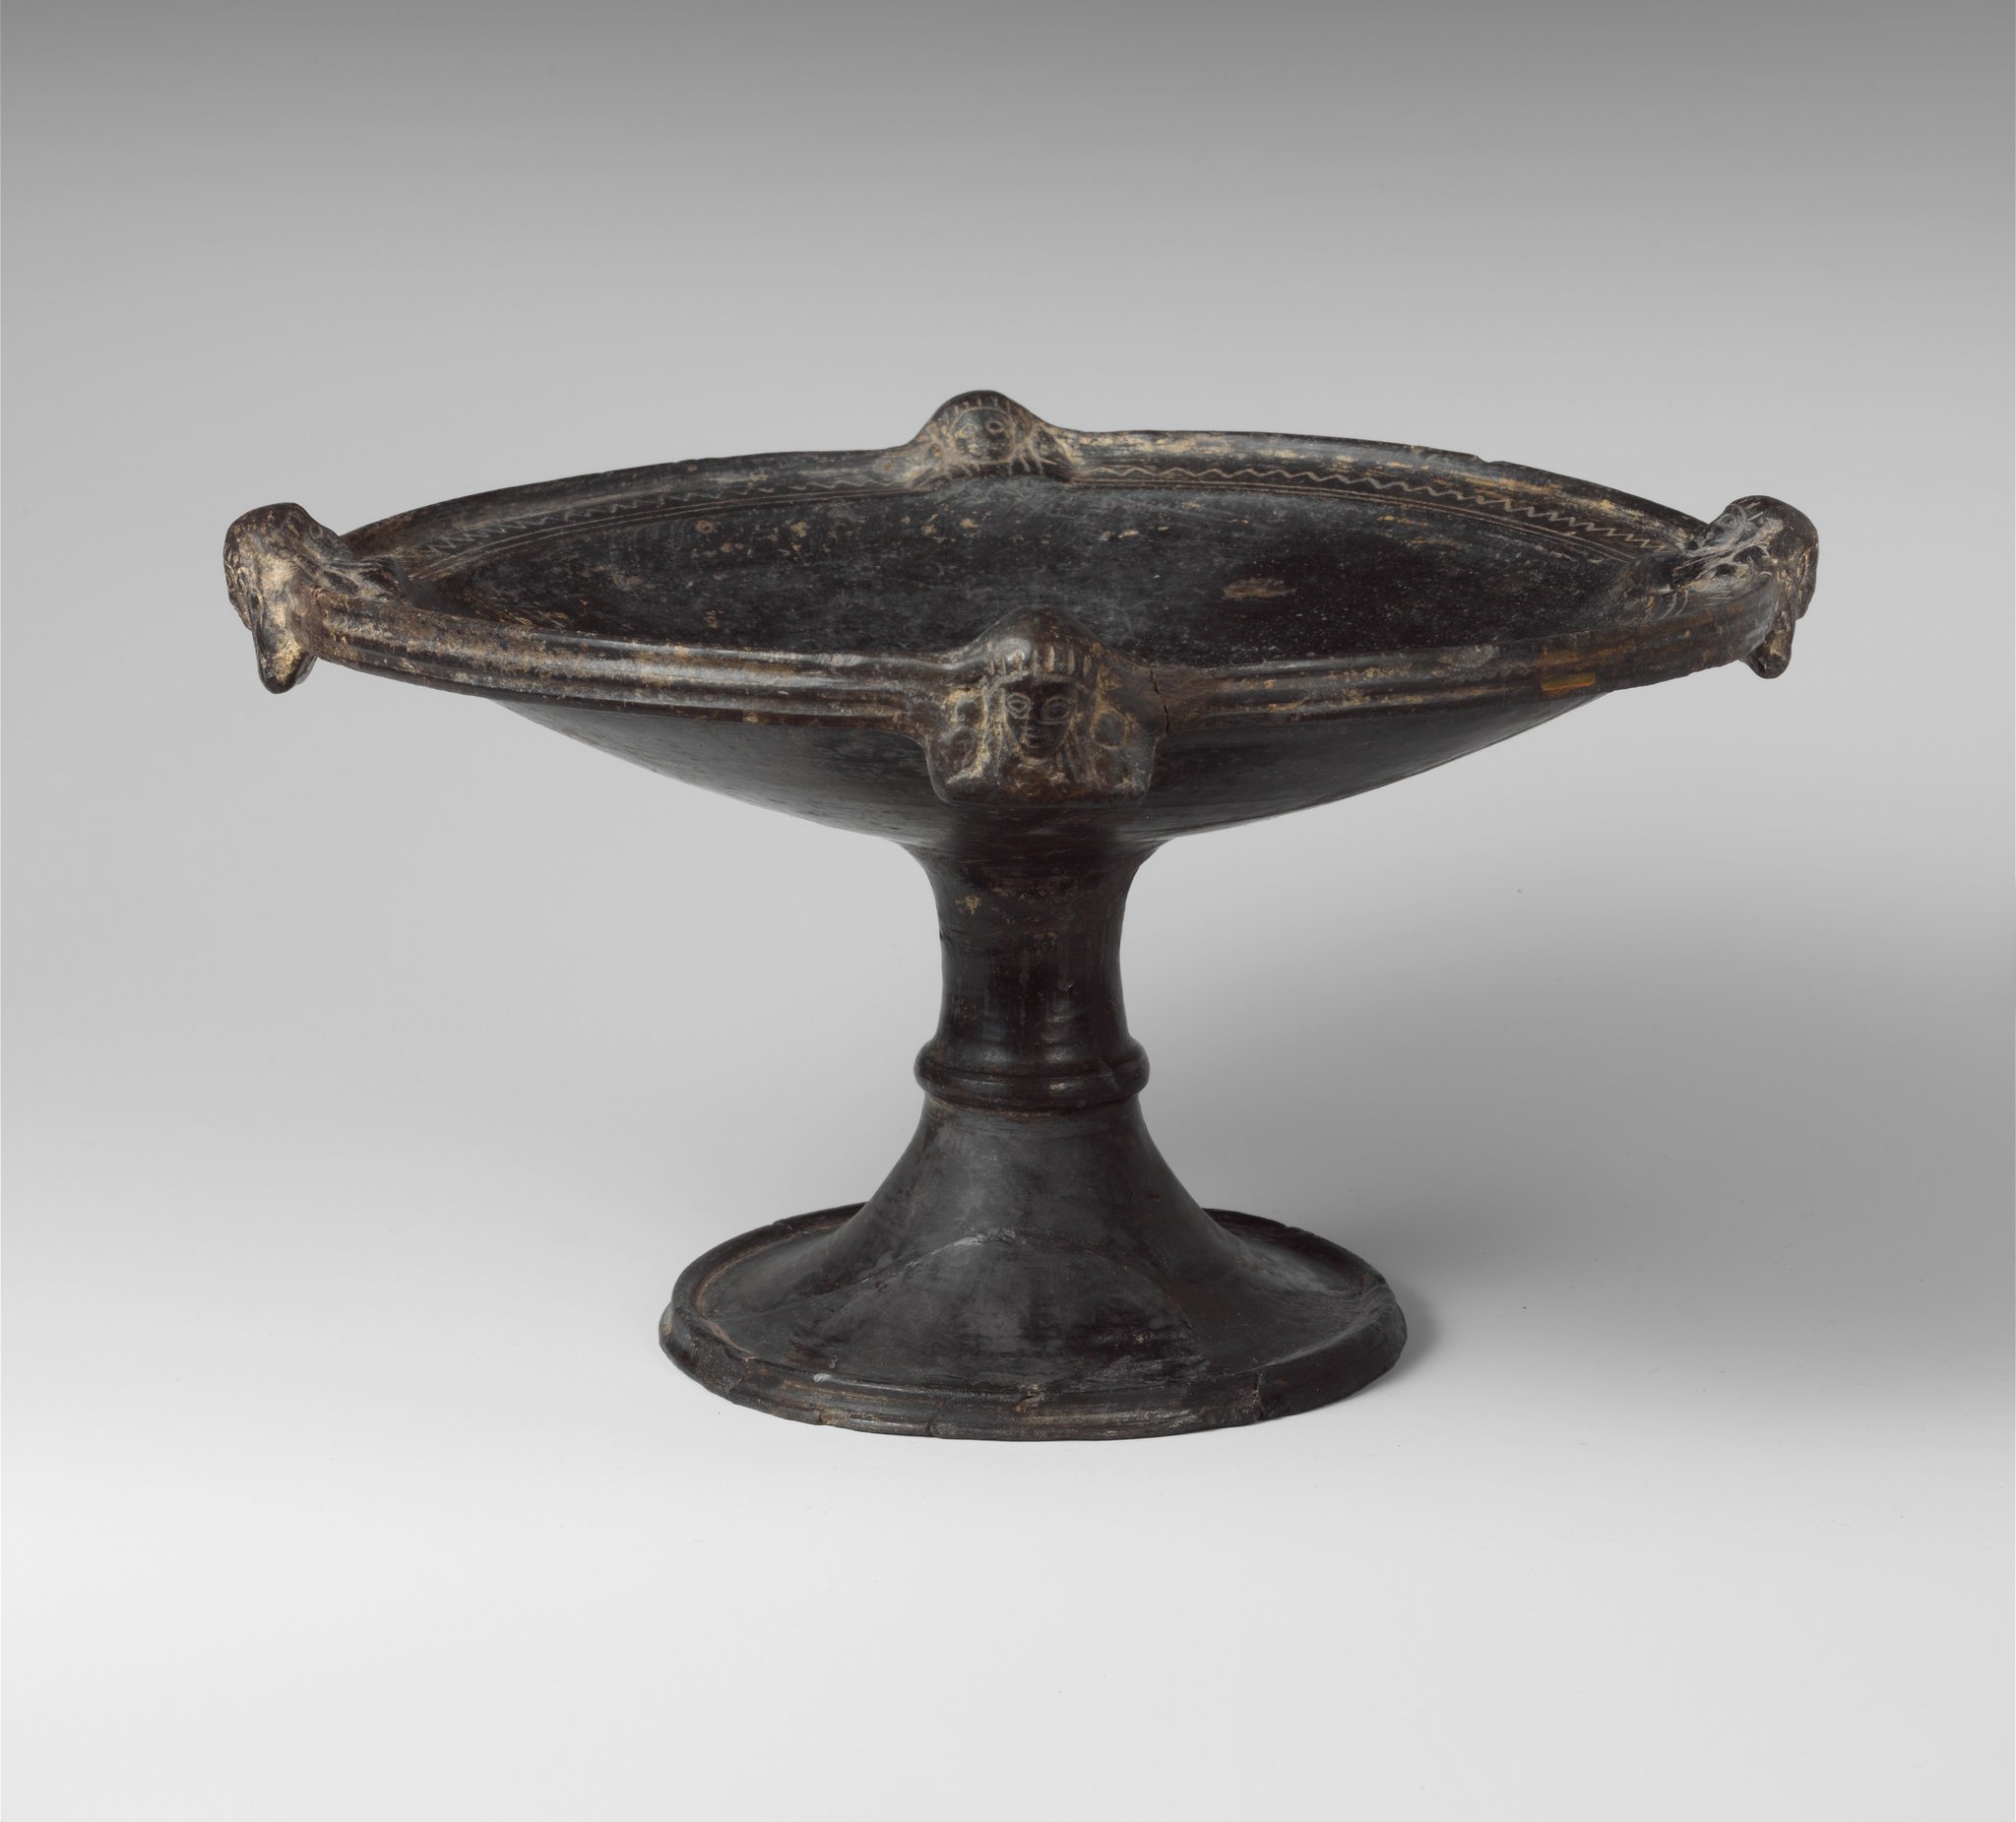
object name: dish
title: Terracotta stemmed dish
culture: etruscan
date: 600-501 BCE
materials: terracotta